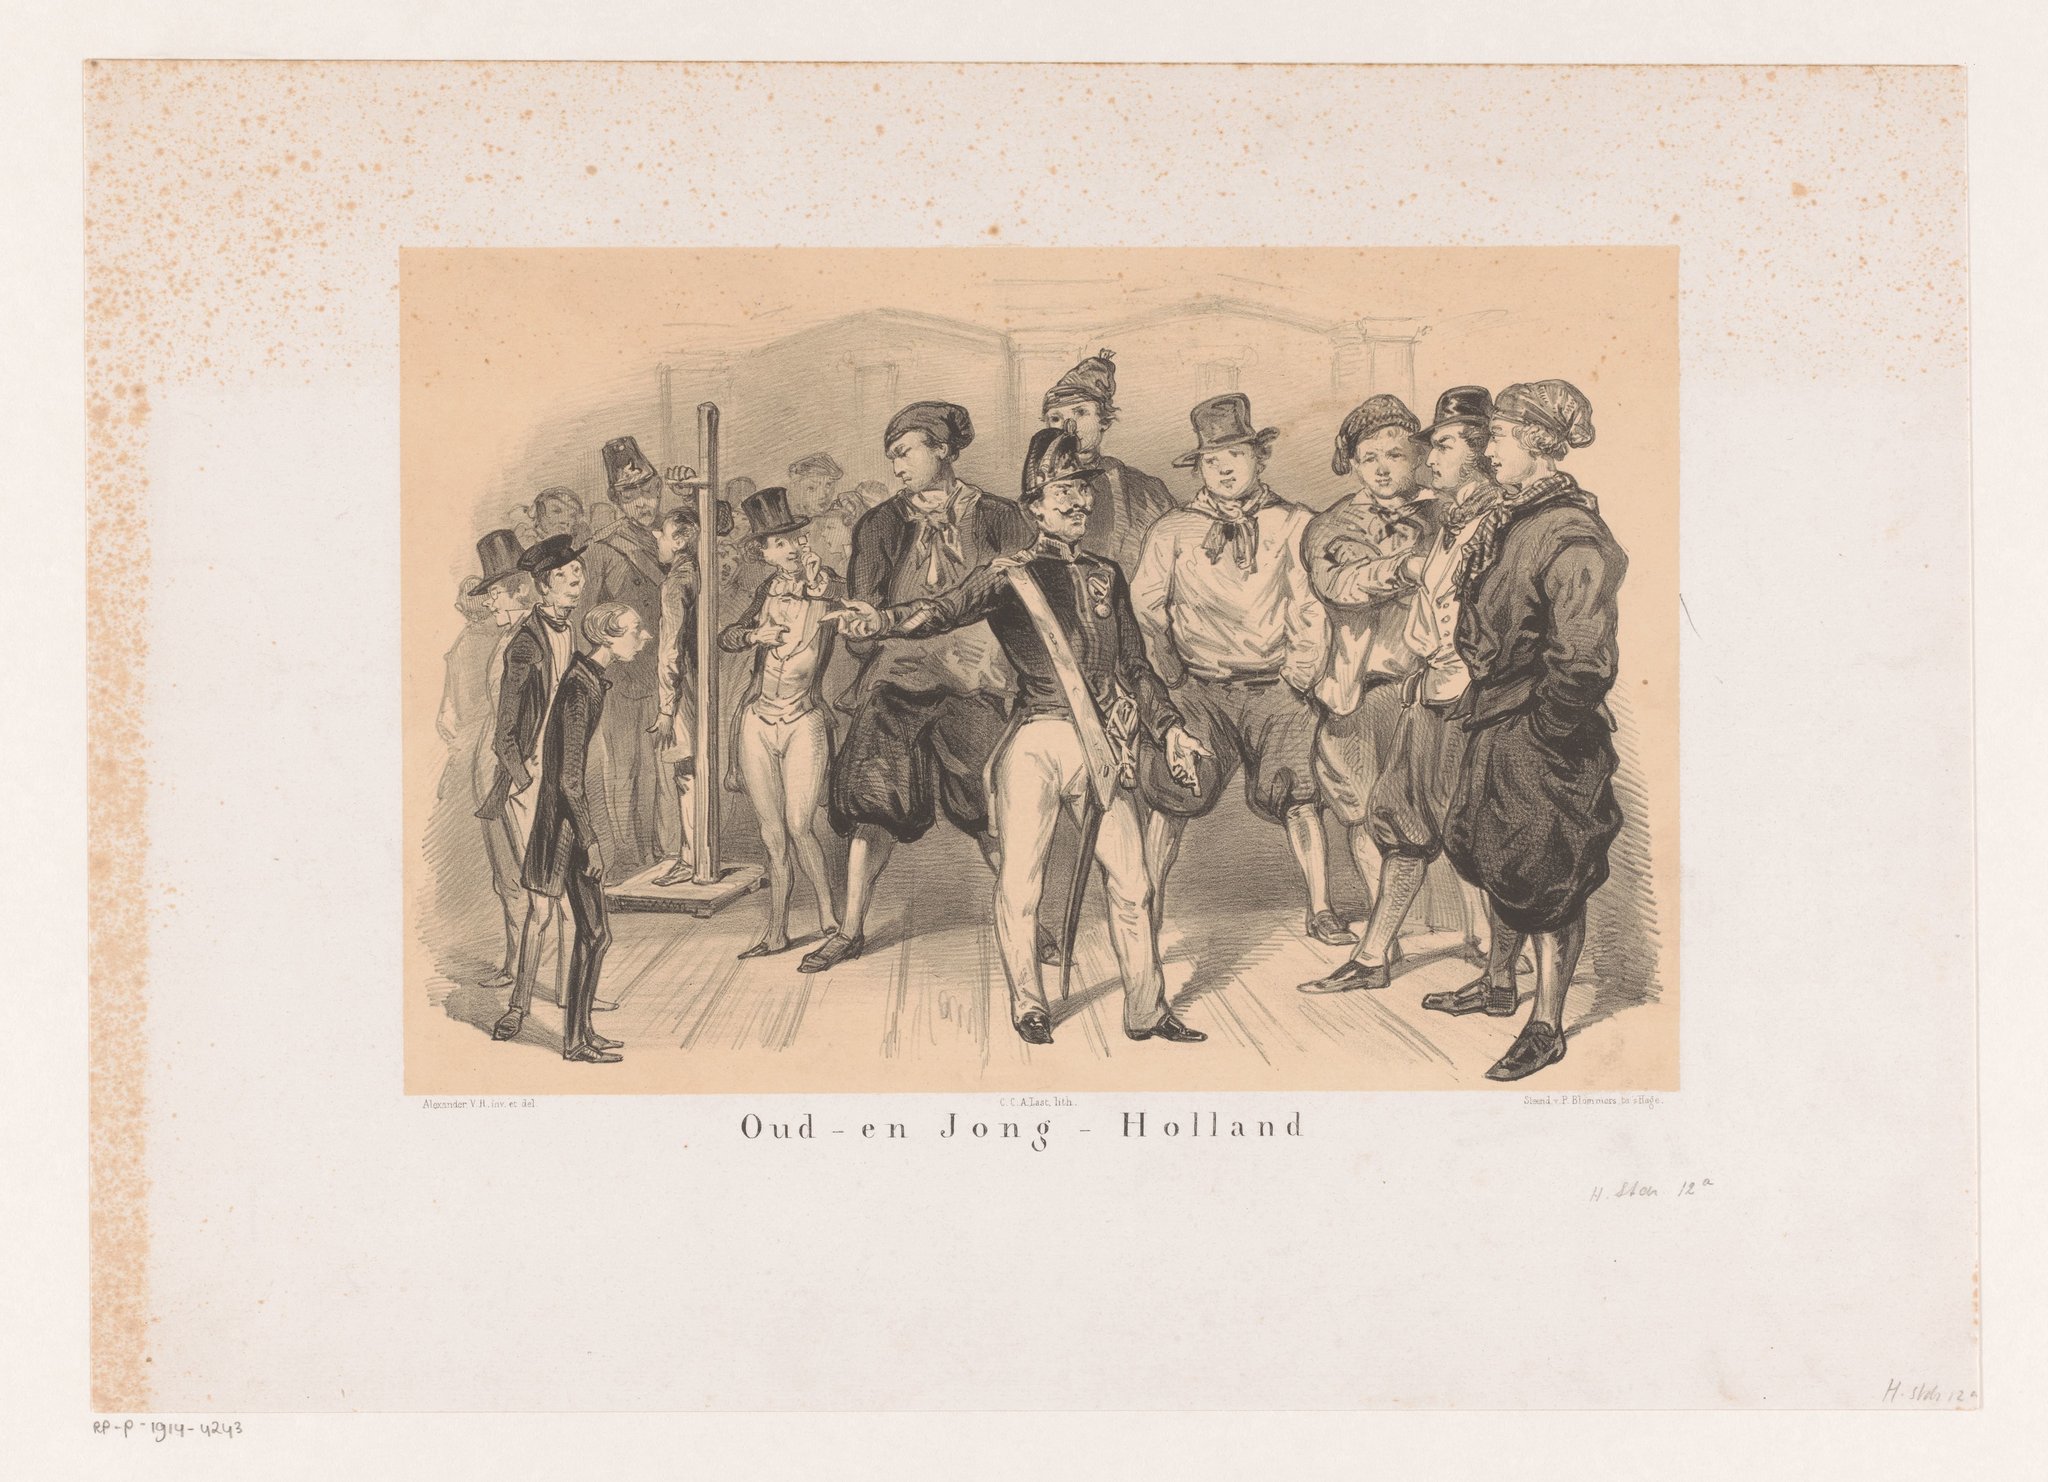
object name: print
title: Jongens en een officier bij een meetlat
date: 1843-1876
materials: paper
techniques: tone lithography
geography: the hague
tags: measuring the child, youth, adolescent, officer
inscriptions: collector's mark: Lugt 2228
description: De jongens staan in de rij om te worden gemeten bij een meetlat. In het midden staat een officier. Links staan kleine dunne jongens in nette kleding. Rechts staan grote stevige jongens in oud-Hollandse kleding.